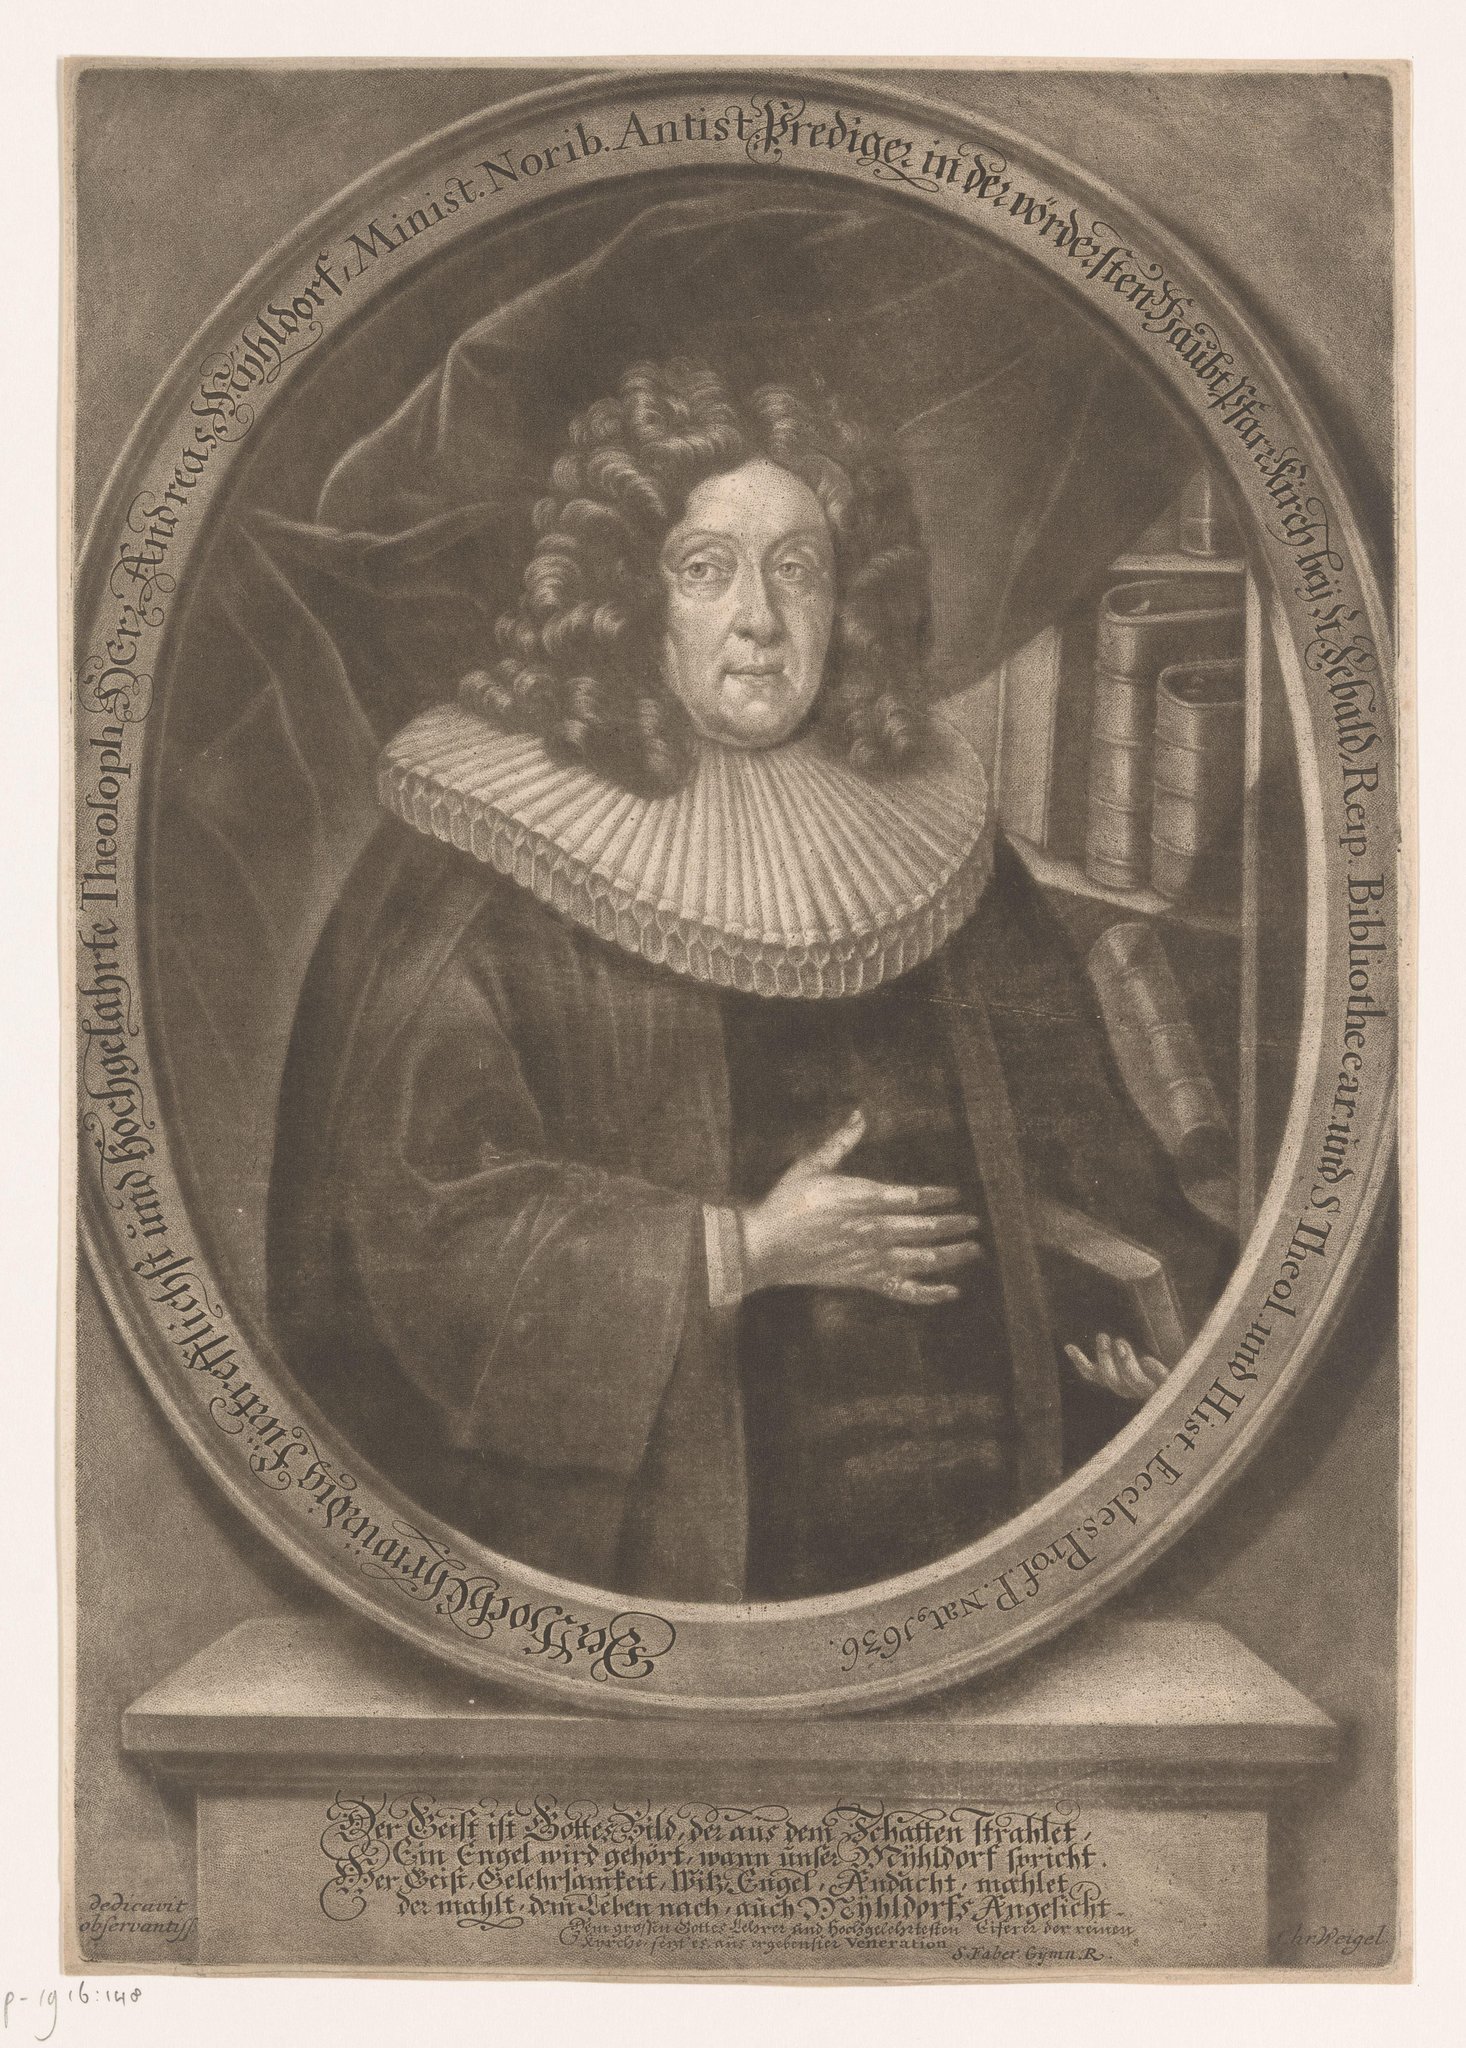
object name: print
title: Portret van Andreas Myhldorf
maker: christoph weigel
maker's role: goldsmith, print maker, publisher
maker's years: 1654-1725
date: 1664-1725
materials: paper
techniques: mezzotint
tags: historical persons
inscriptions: collector's mark: Lugt 2228